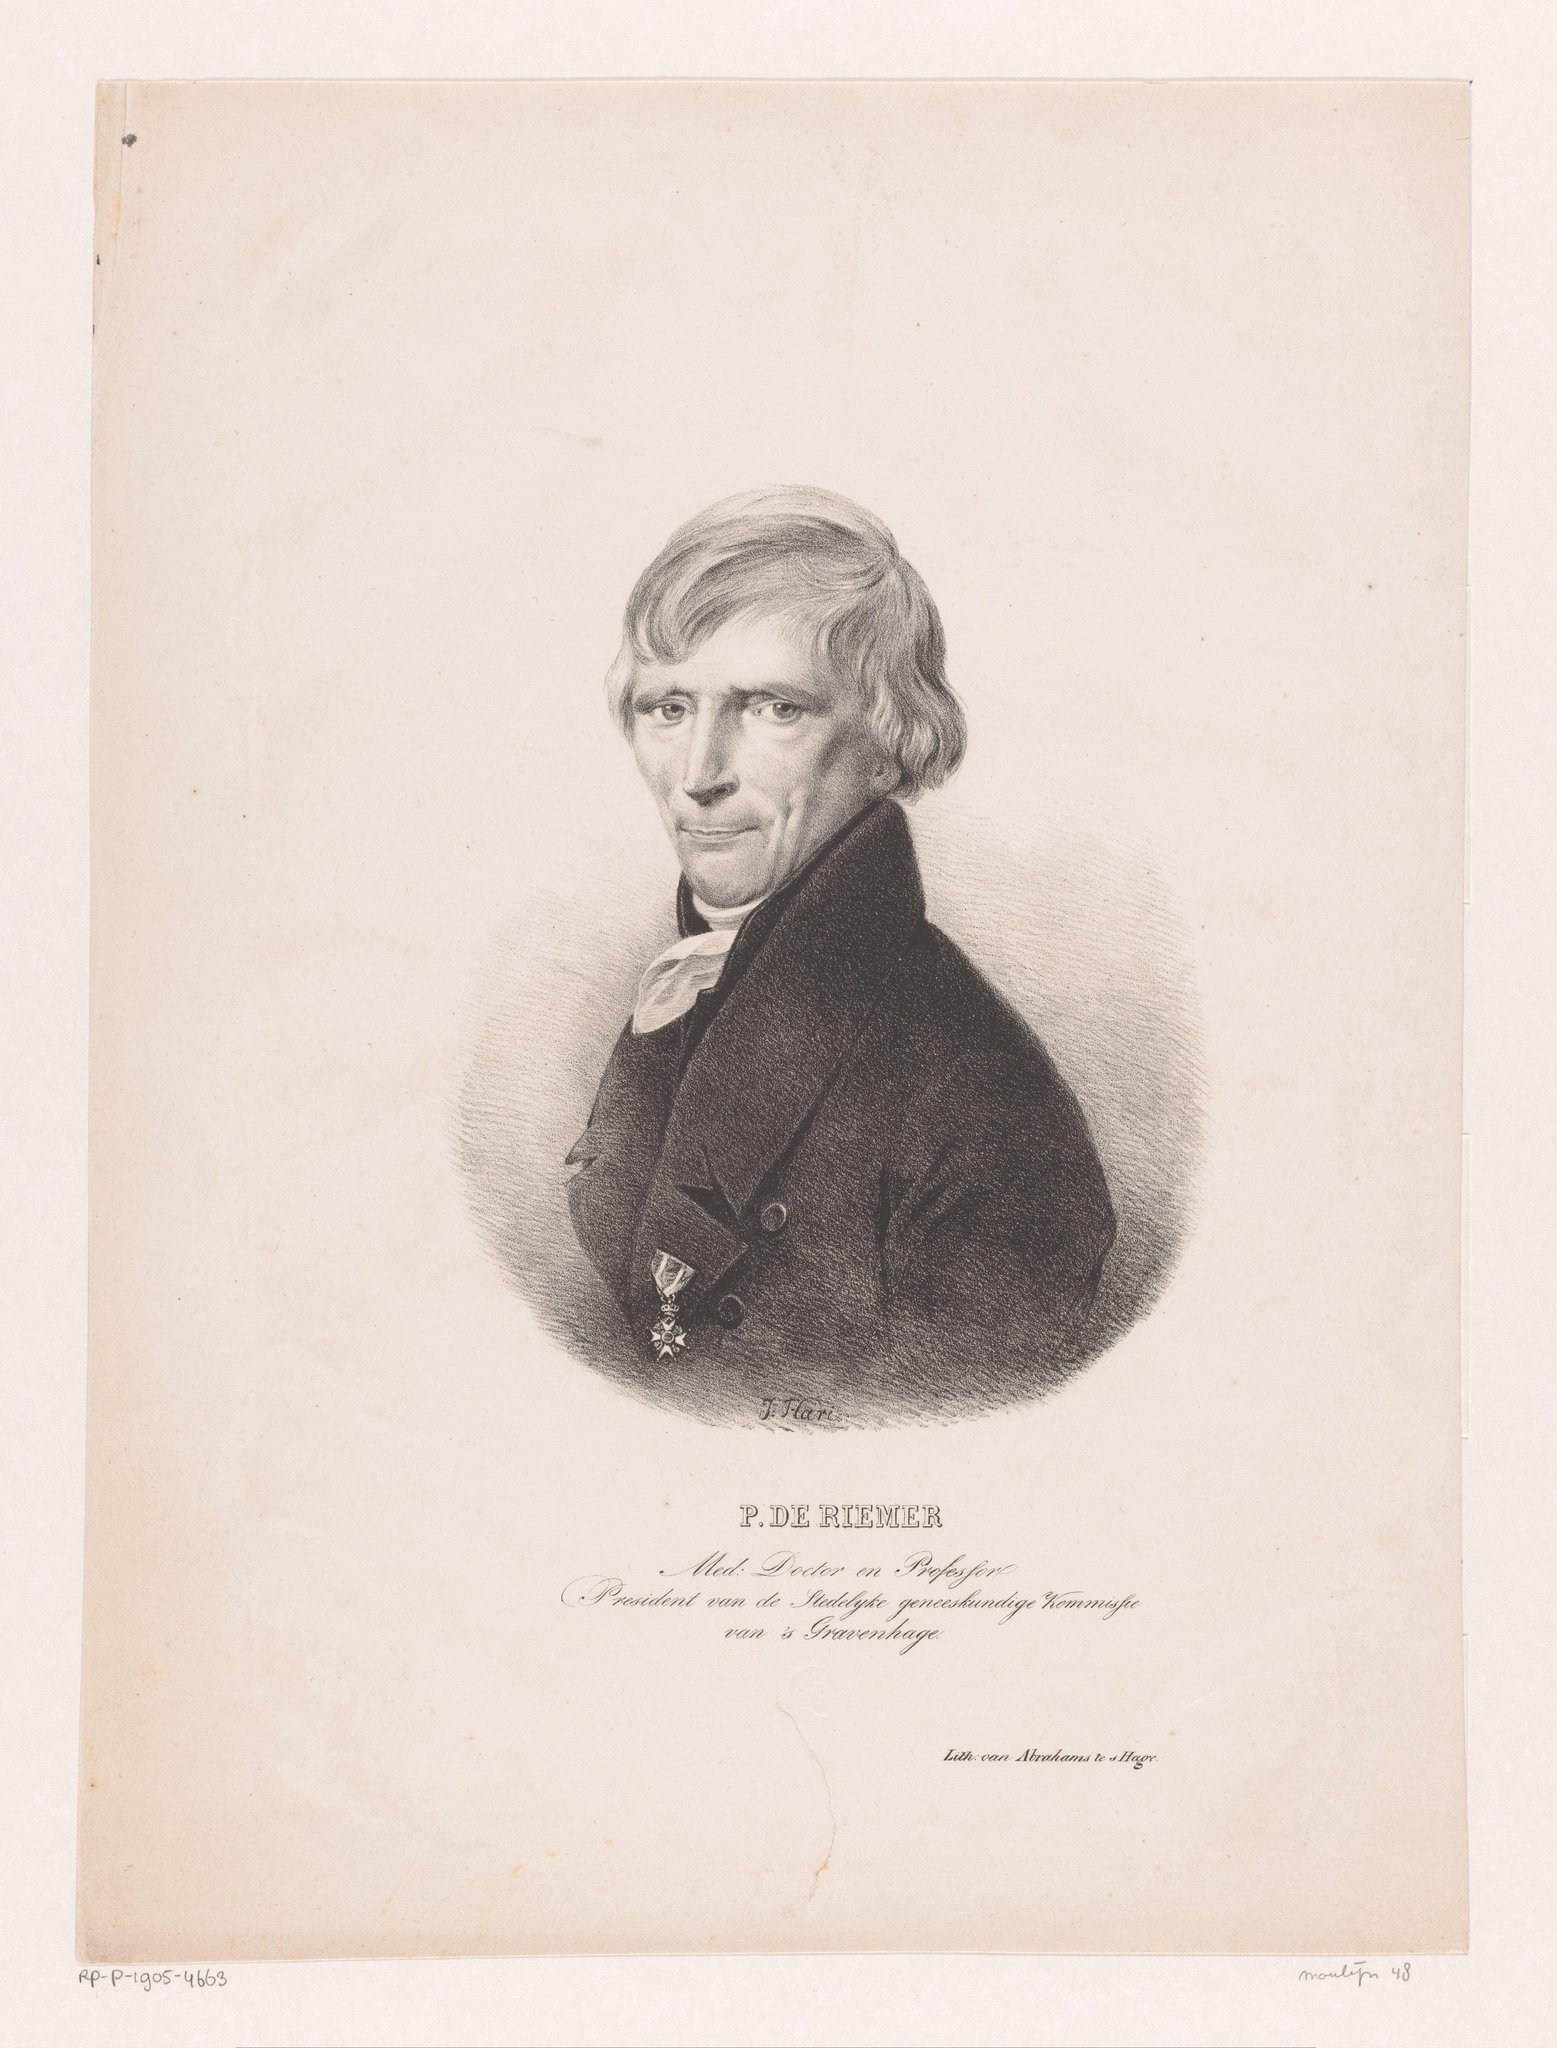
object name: print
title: Portret van Pieter de Riemer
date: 1823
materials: paper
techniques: lithograph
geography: the hague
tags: knighthood order, historical persons (+ (full) bust portrait)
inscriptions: collector's mark: Lugt 2228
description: De geportretteerde draagt een ridderorde op zijn jas.